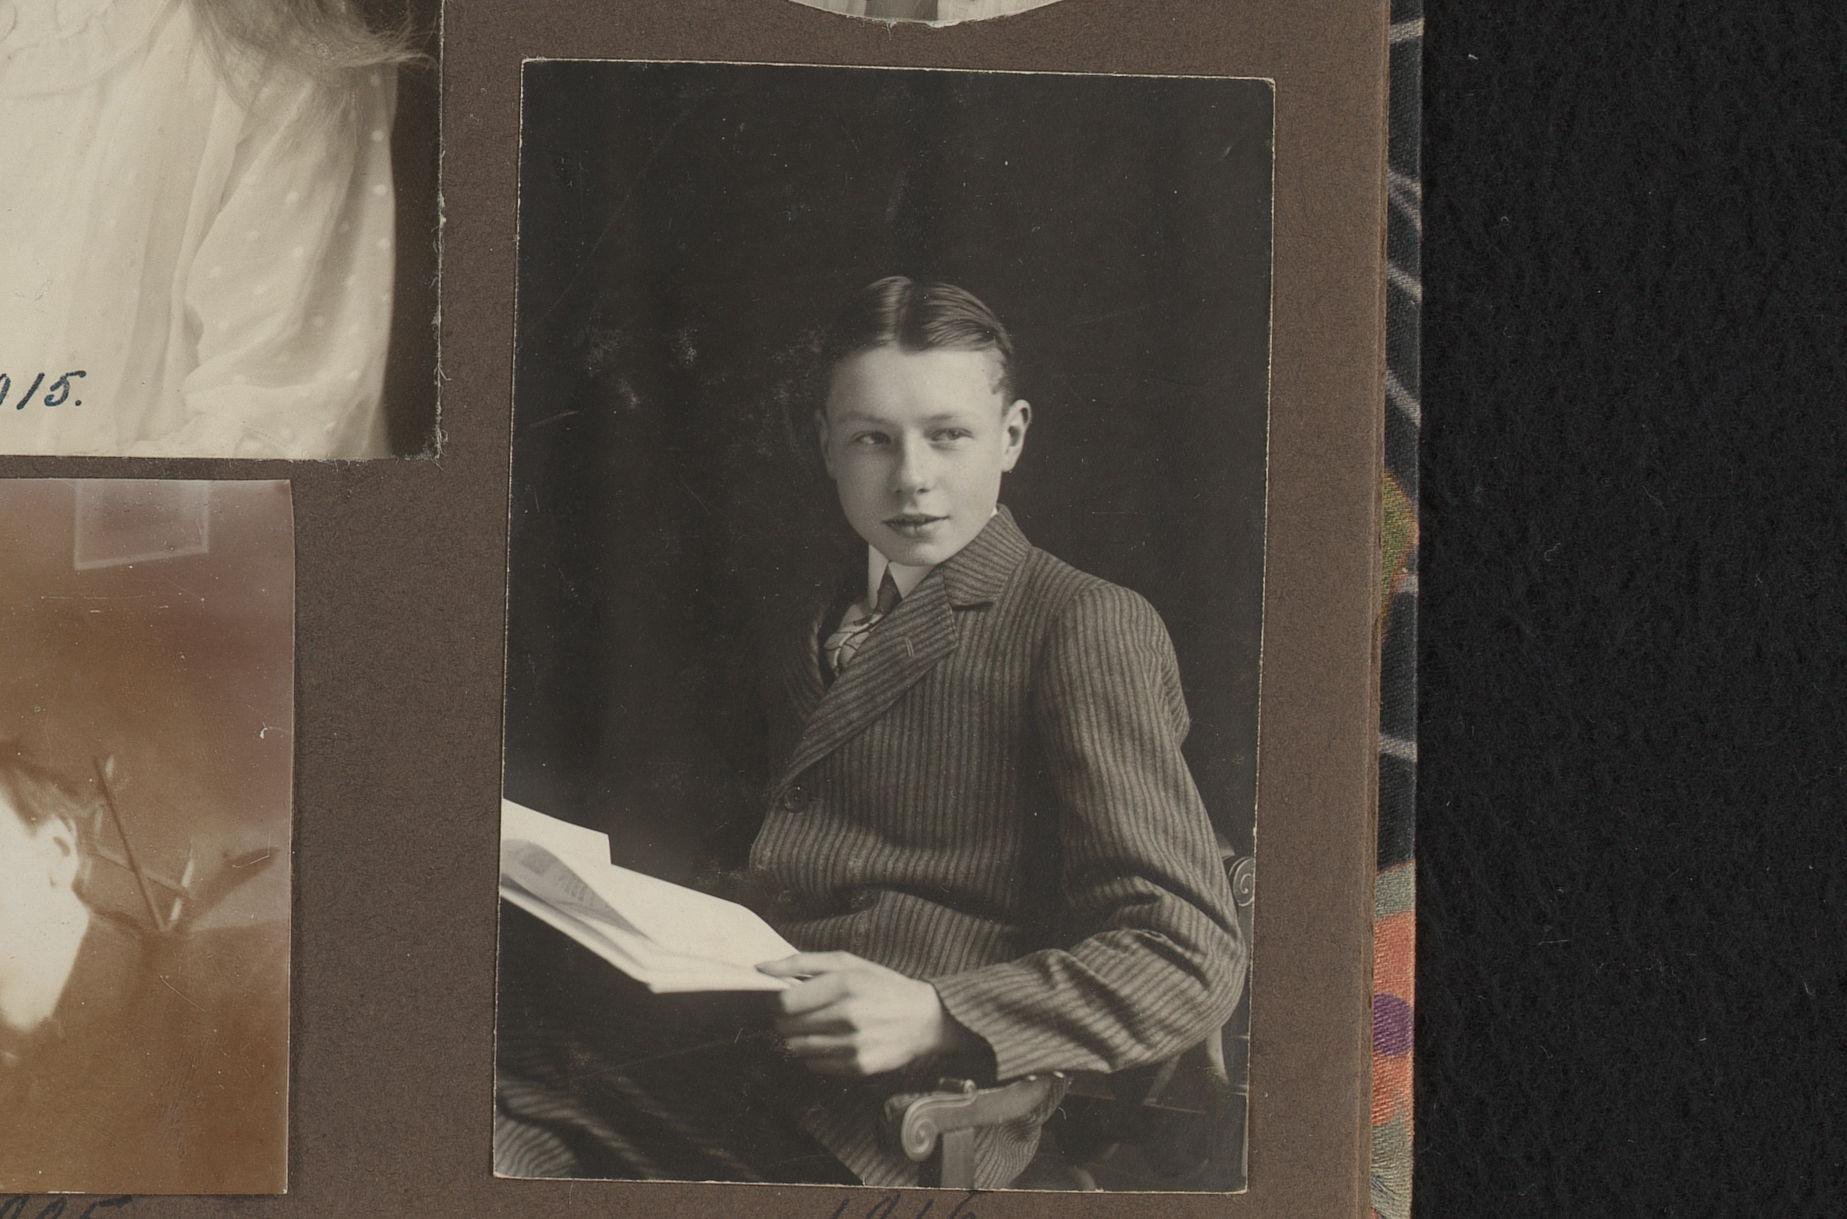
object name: photograph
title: Portret van een jongen met een boek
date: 1916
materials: paper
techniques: gelatin silver print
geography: netherlands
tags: anonymous historical person portrayed alone, youth, adolescent, book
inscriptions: date: ‘1916.’